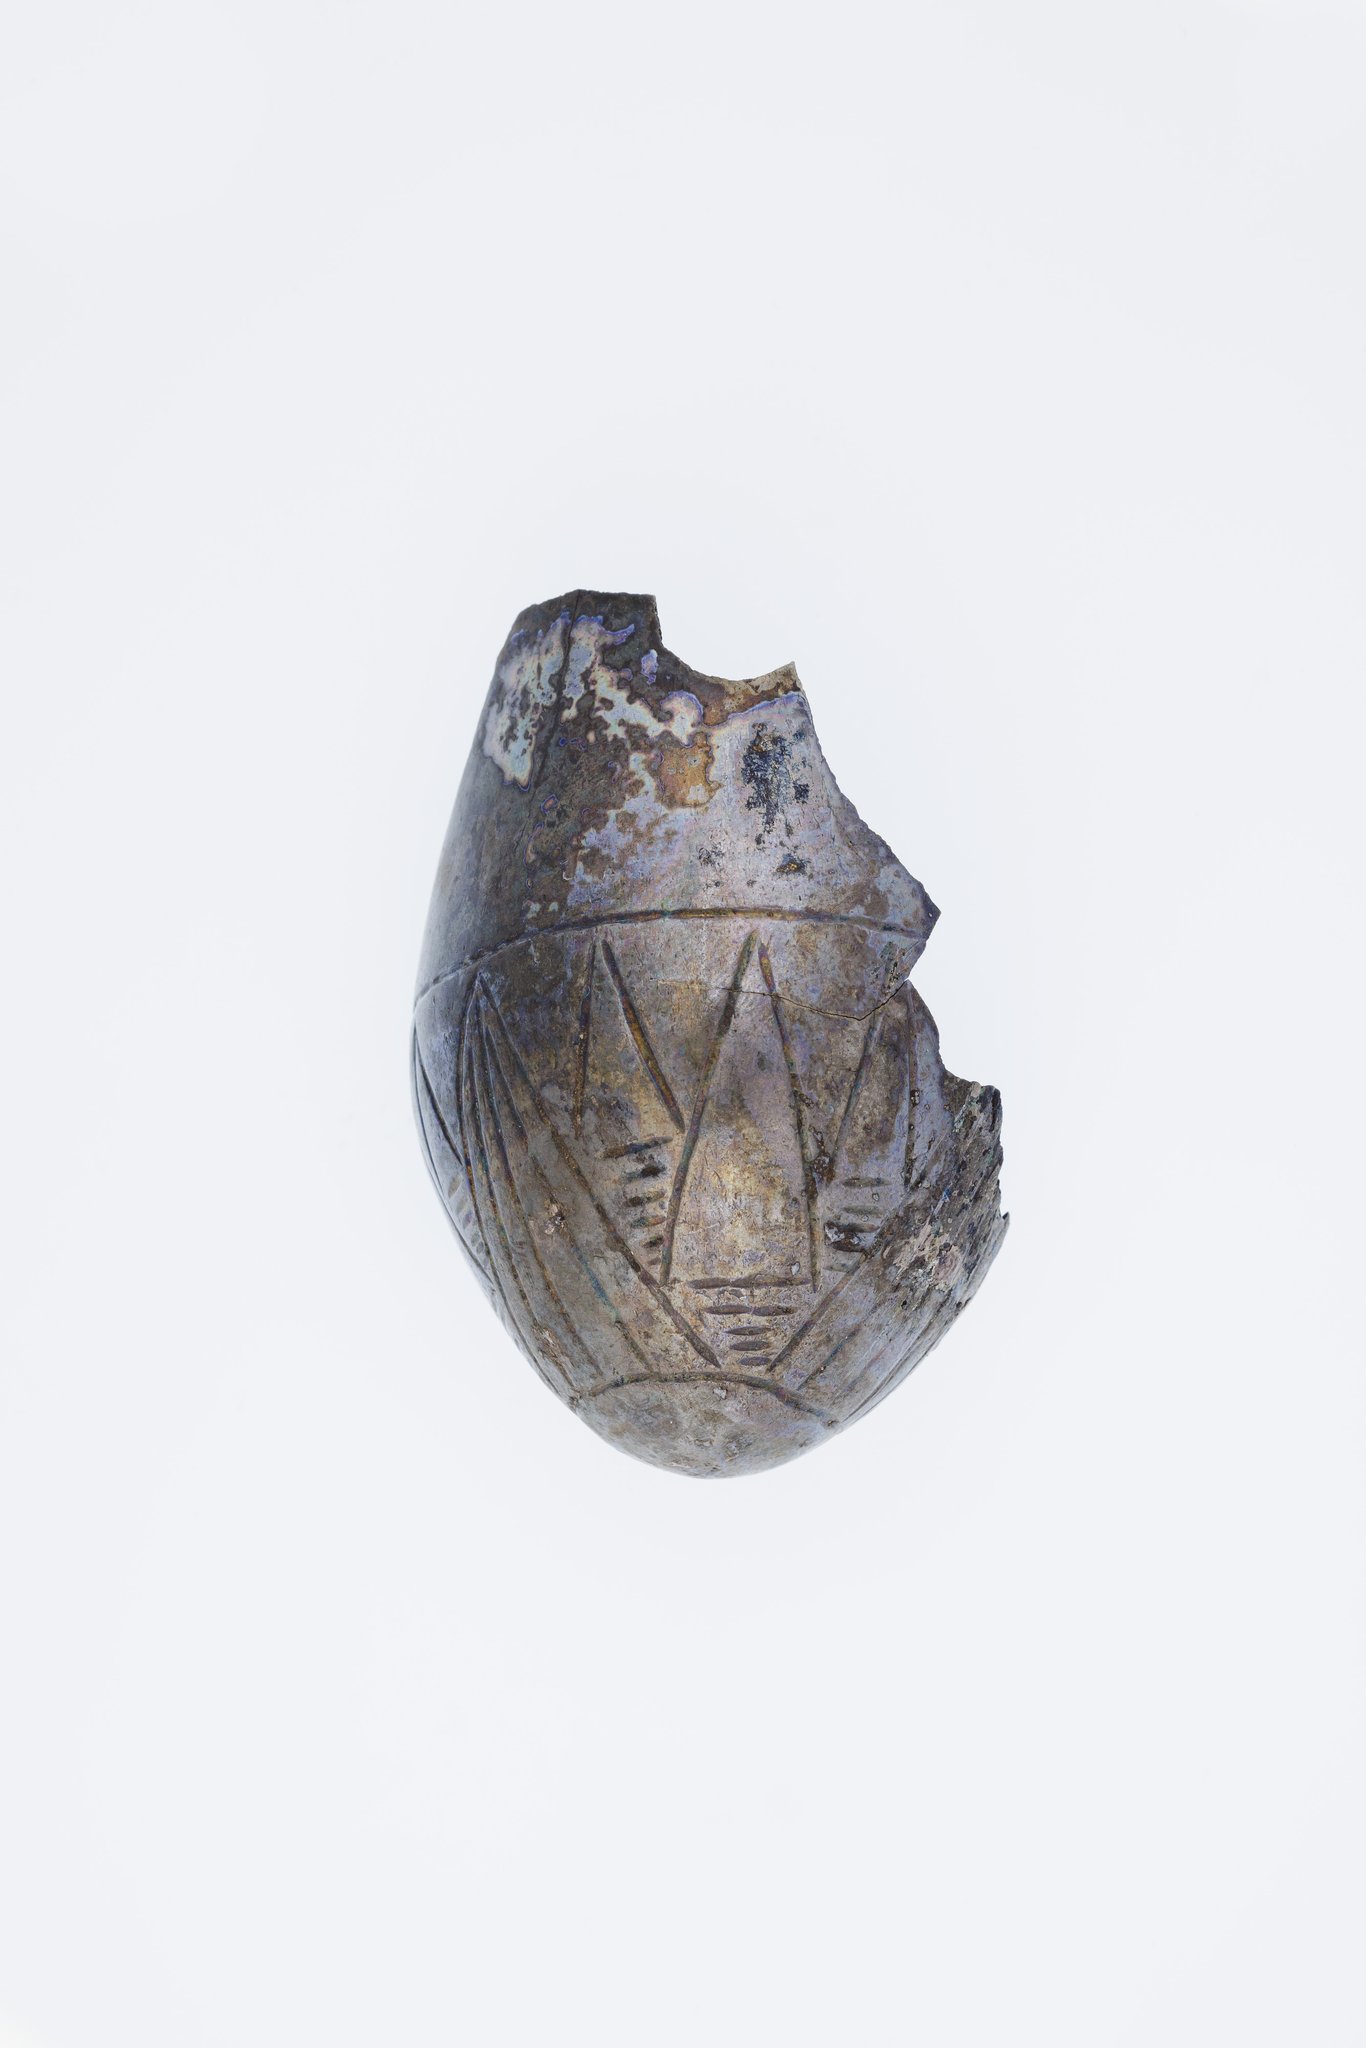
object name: situla fragment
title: Base of a situla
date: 1279-1213 BCE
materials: silver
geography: egypt